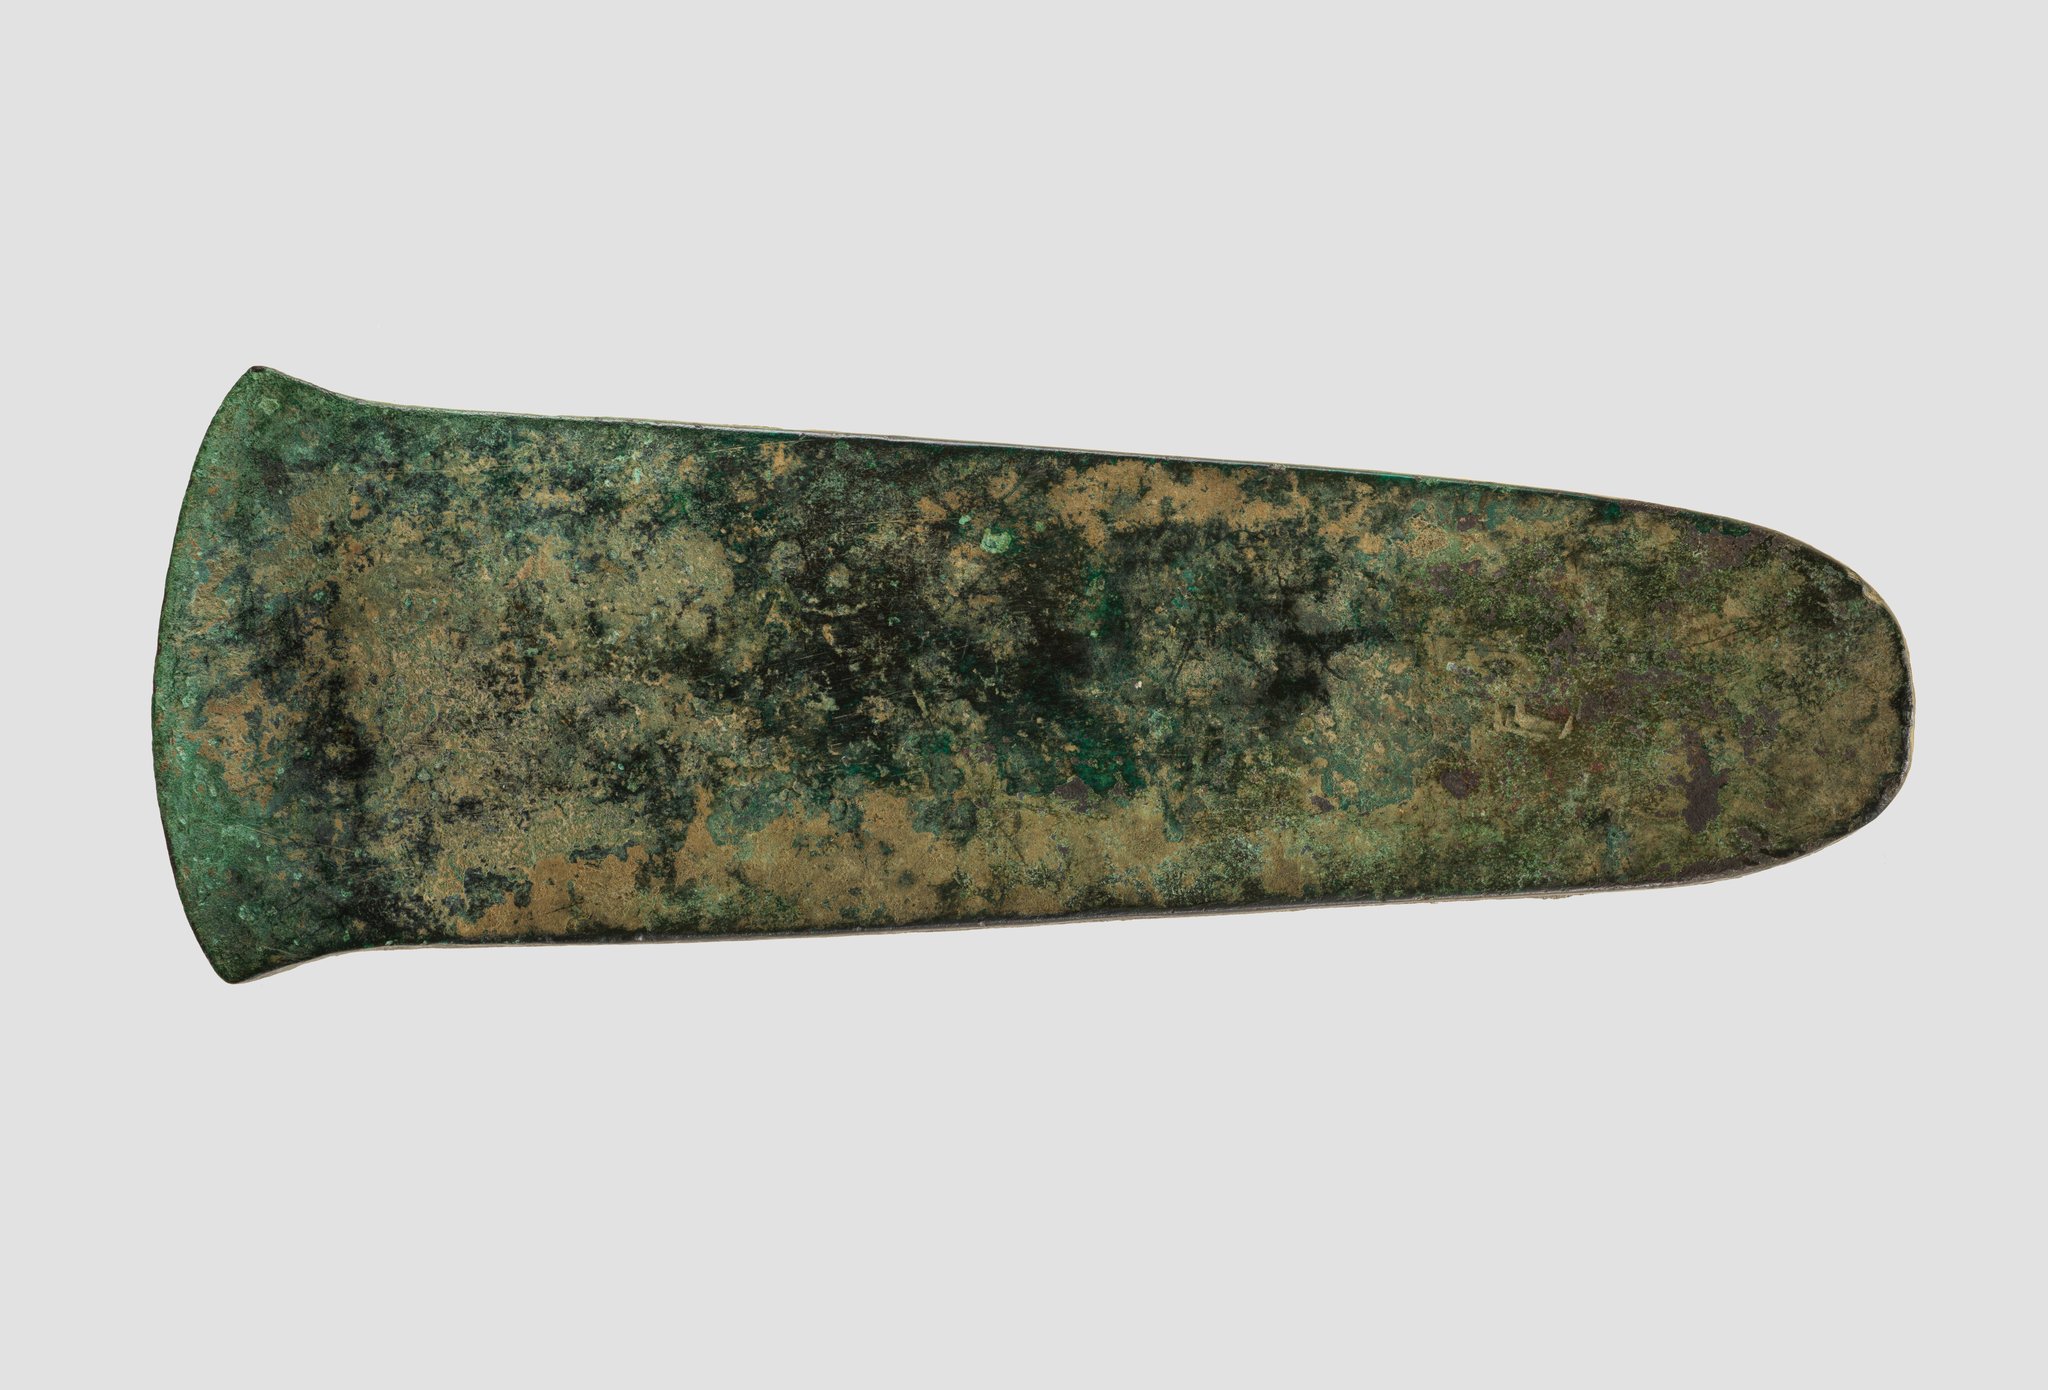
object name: axe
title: Axe head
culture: hattian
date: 2300-2000 BCE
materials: bronze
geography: central anatolia